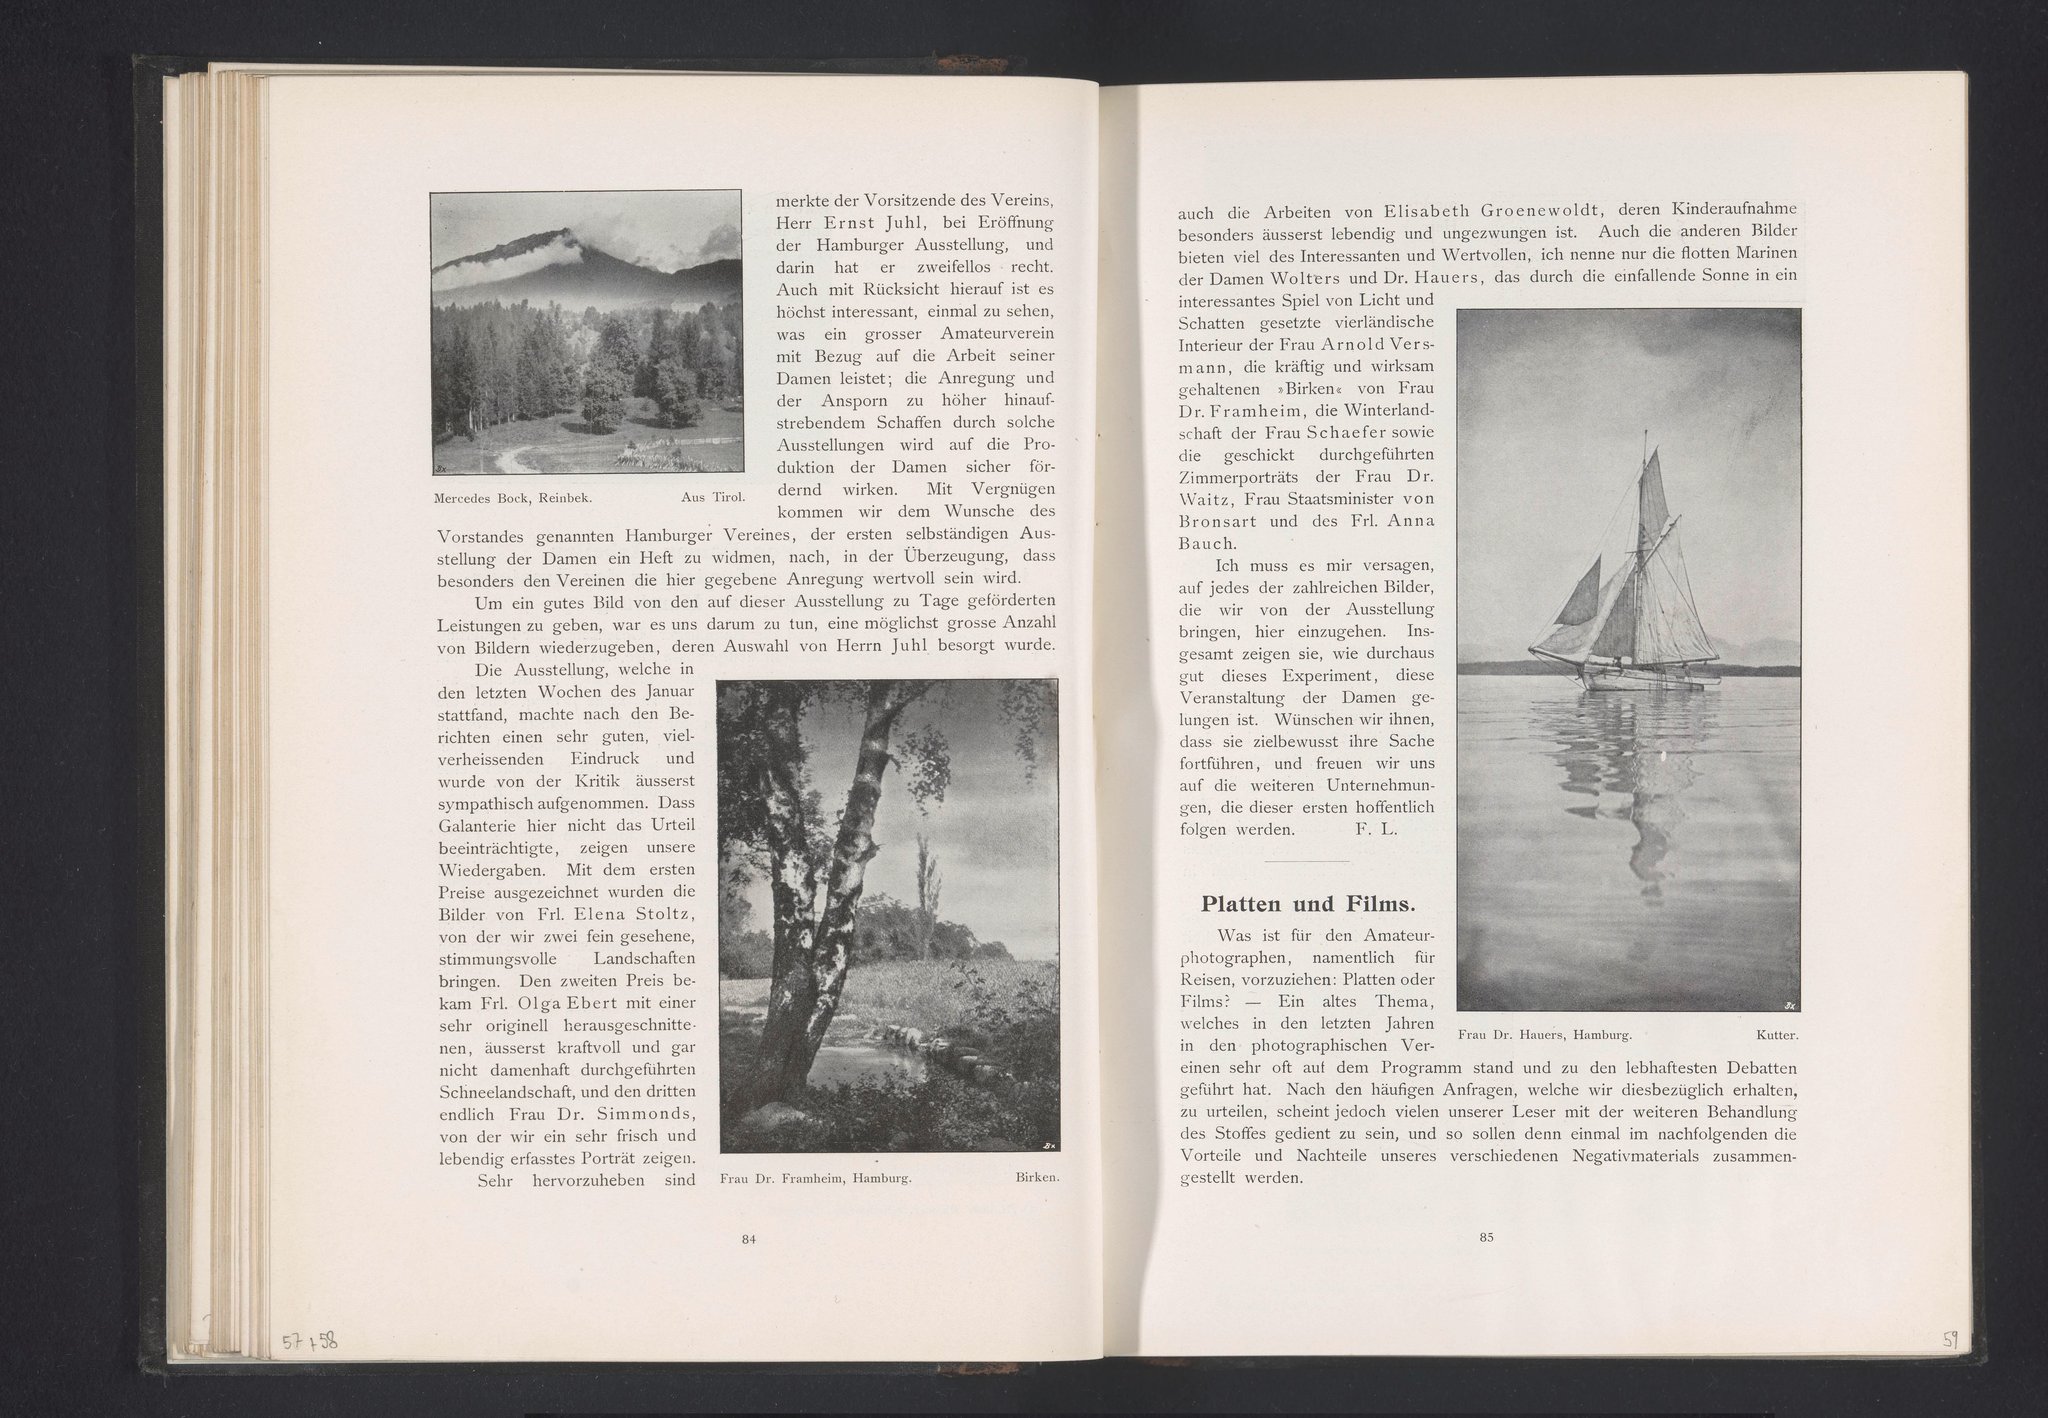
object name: photomechanical print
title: Landschap met berkenboom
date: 1898-1903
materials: paper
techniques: autotype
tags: landscapes, trees: birch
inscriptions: inscription: ‘Frau Dr. Framheim, Hamburg’, monogram: ‘BX’